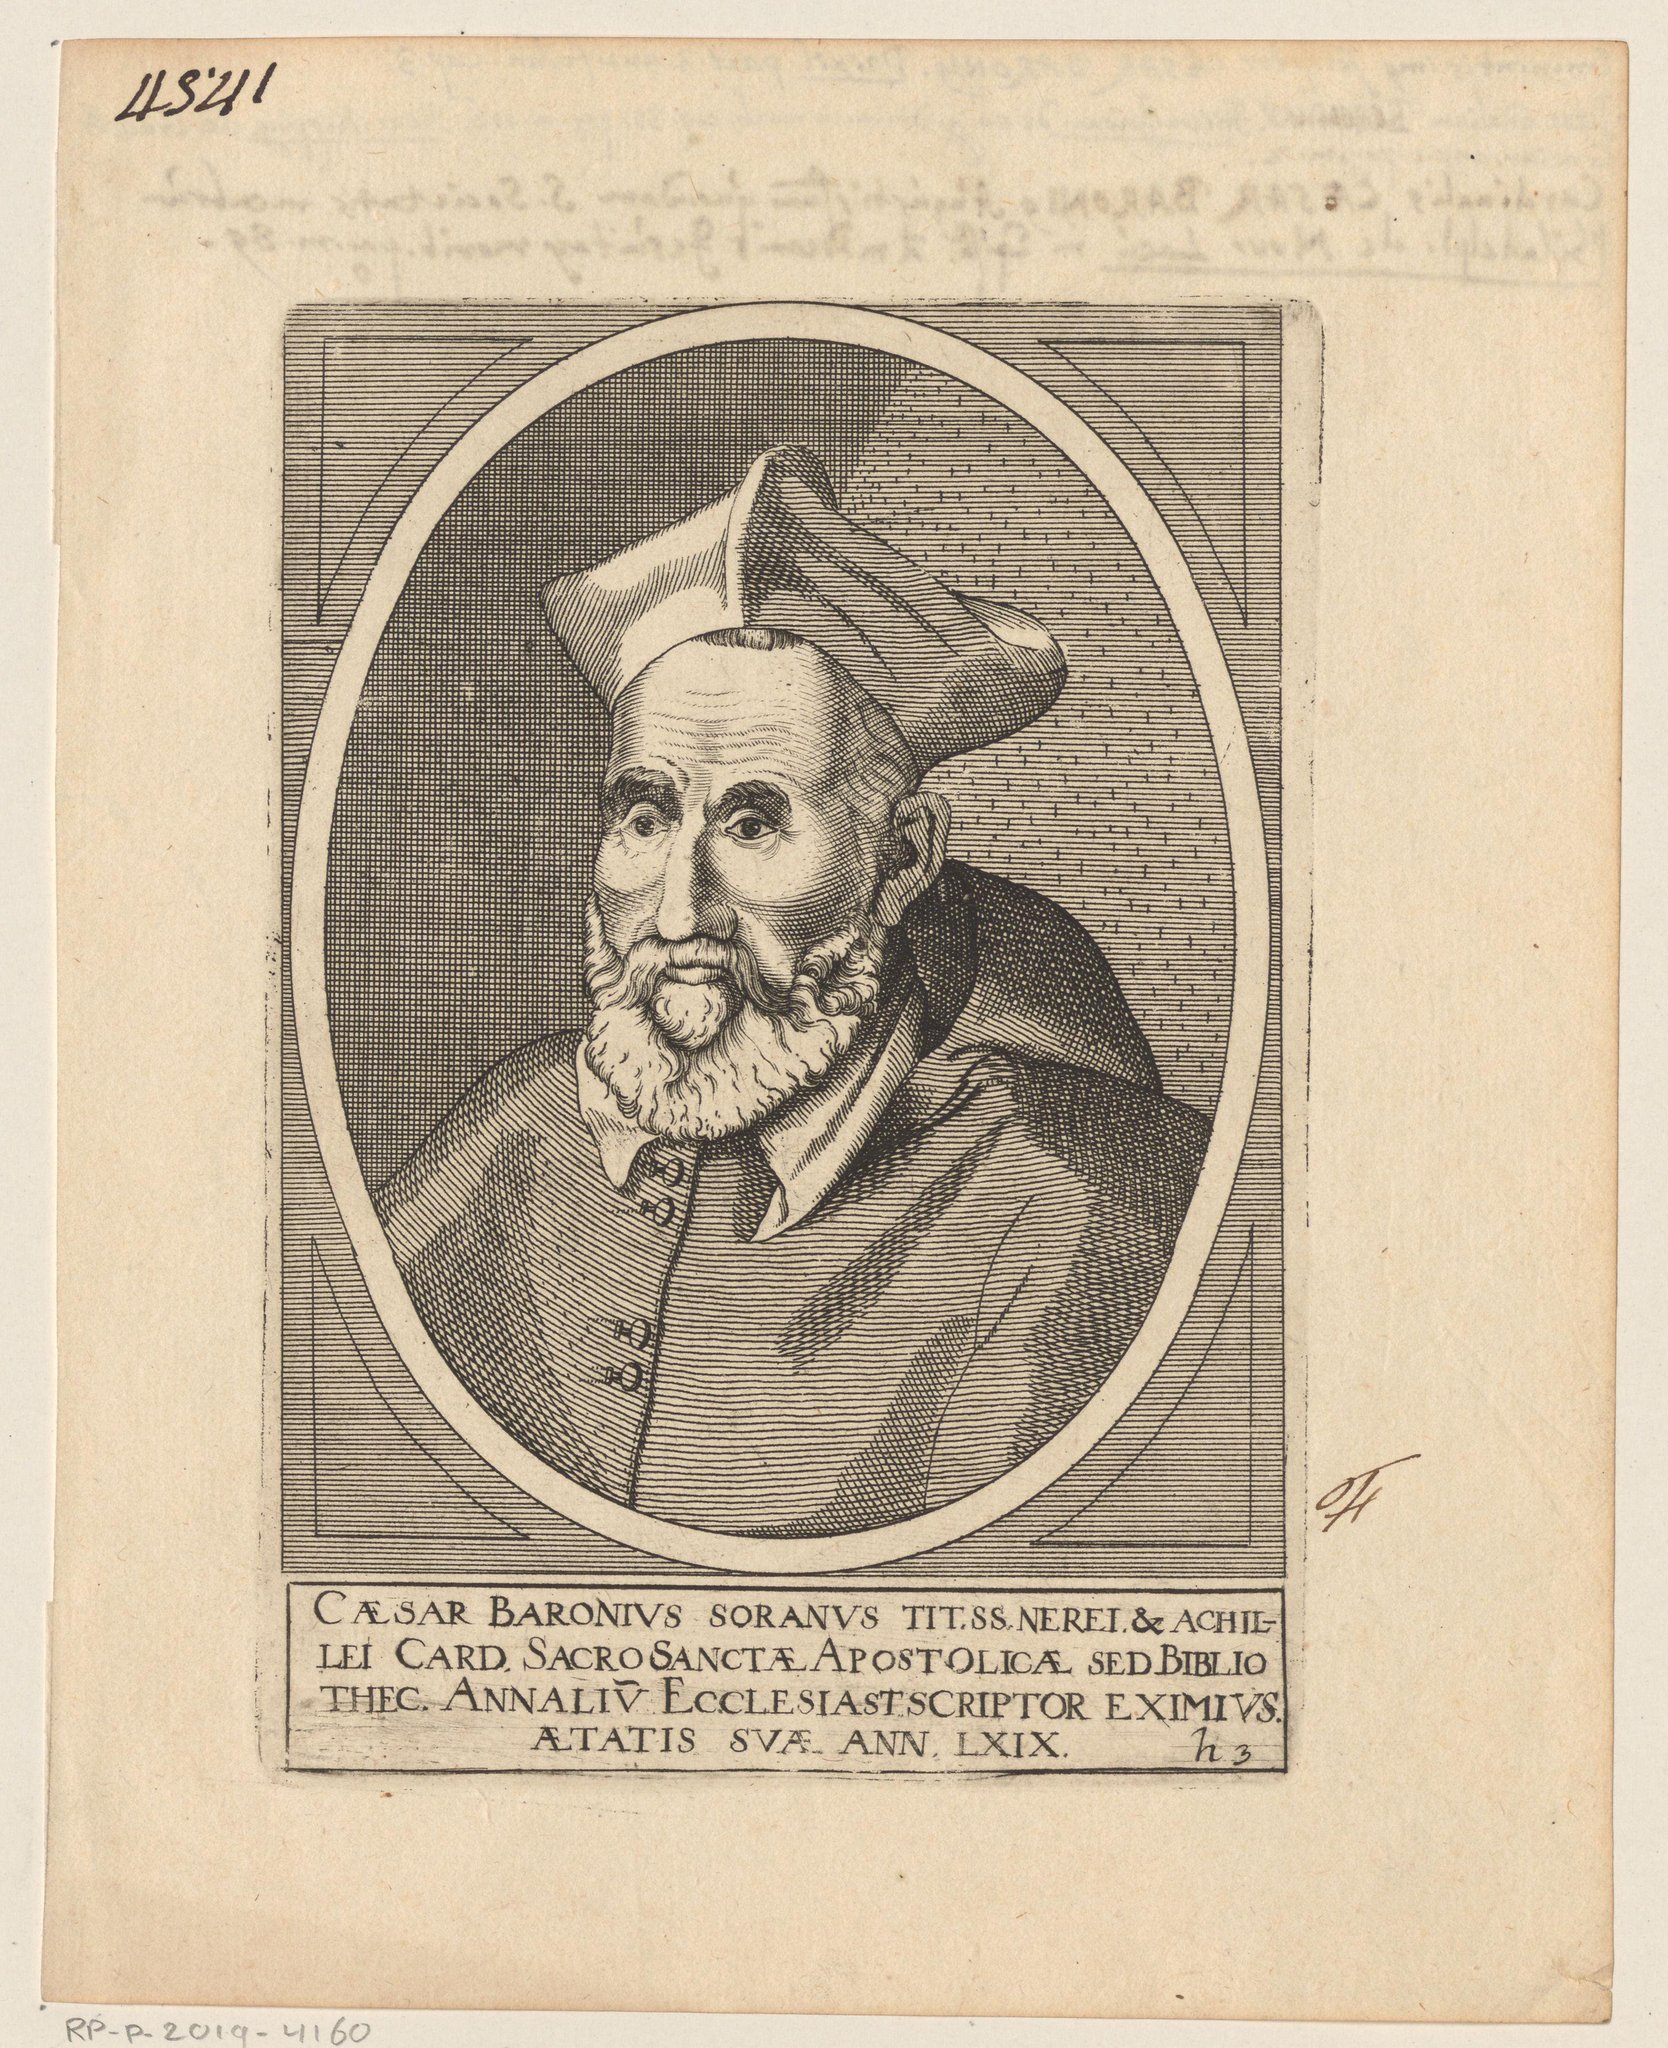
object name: print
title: Portret van Cesare Baronio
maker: Anonymous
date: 1600-1649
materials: paper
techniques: engraving, etching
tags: rome, historical persons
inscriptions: inscription: ‘Eminentissim[us] scritpor Caesar Baroni[us]. Drexel. part. 3. [...]’, inscription: ‘4541’